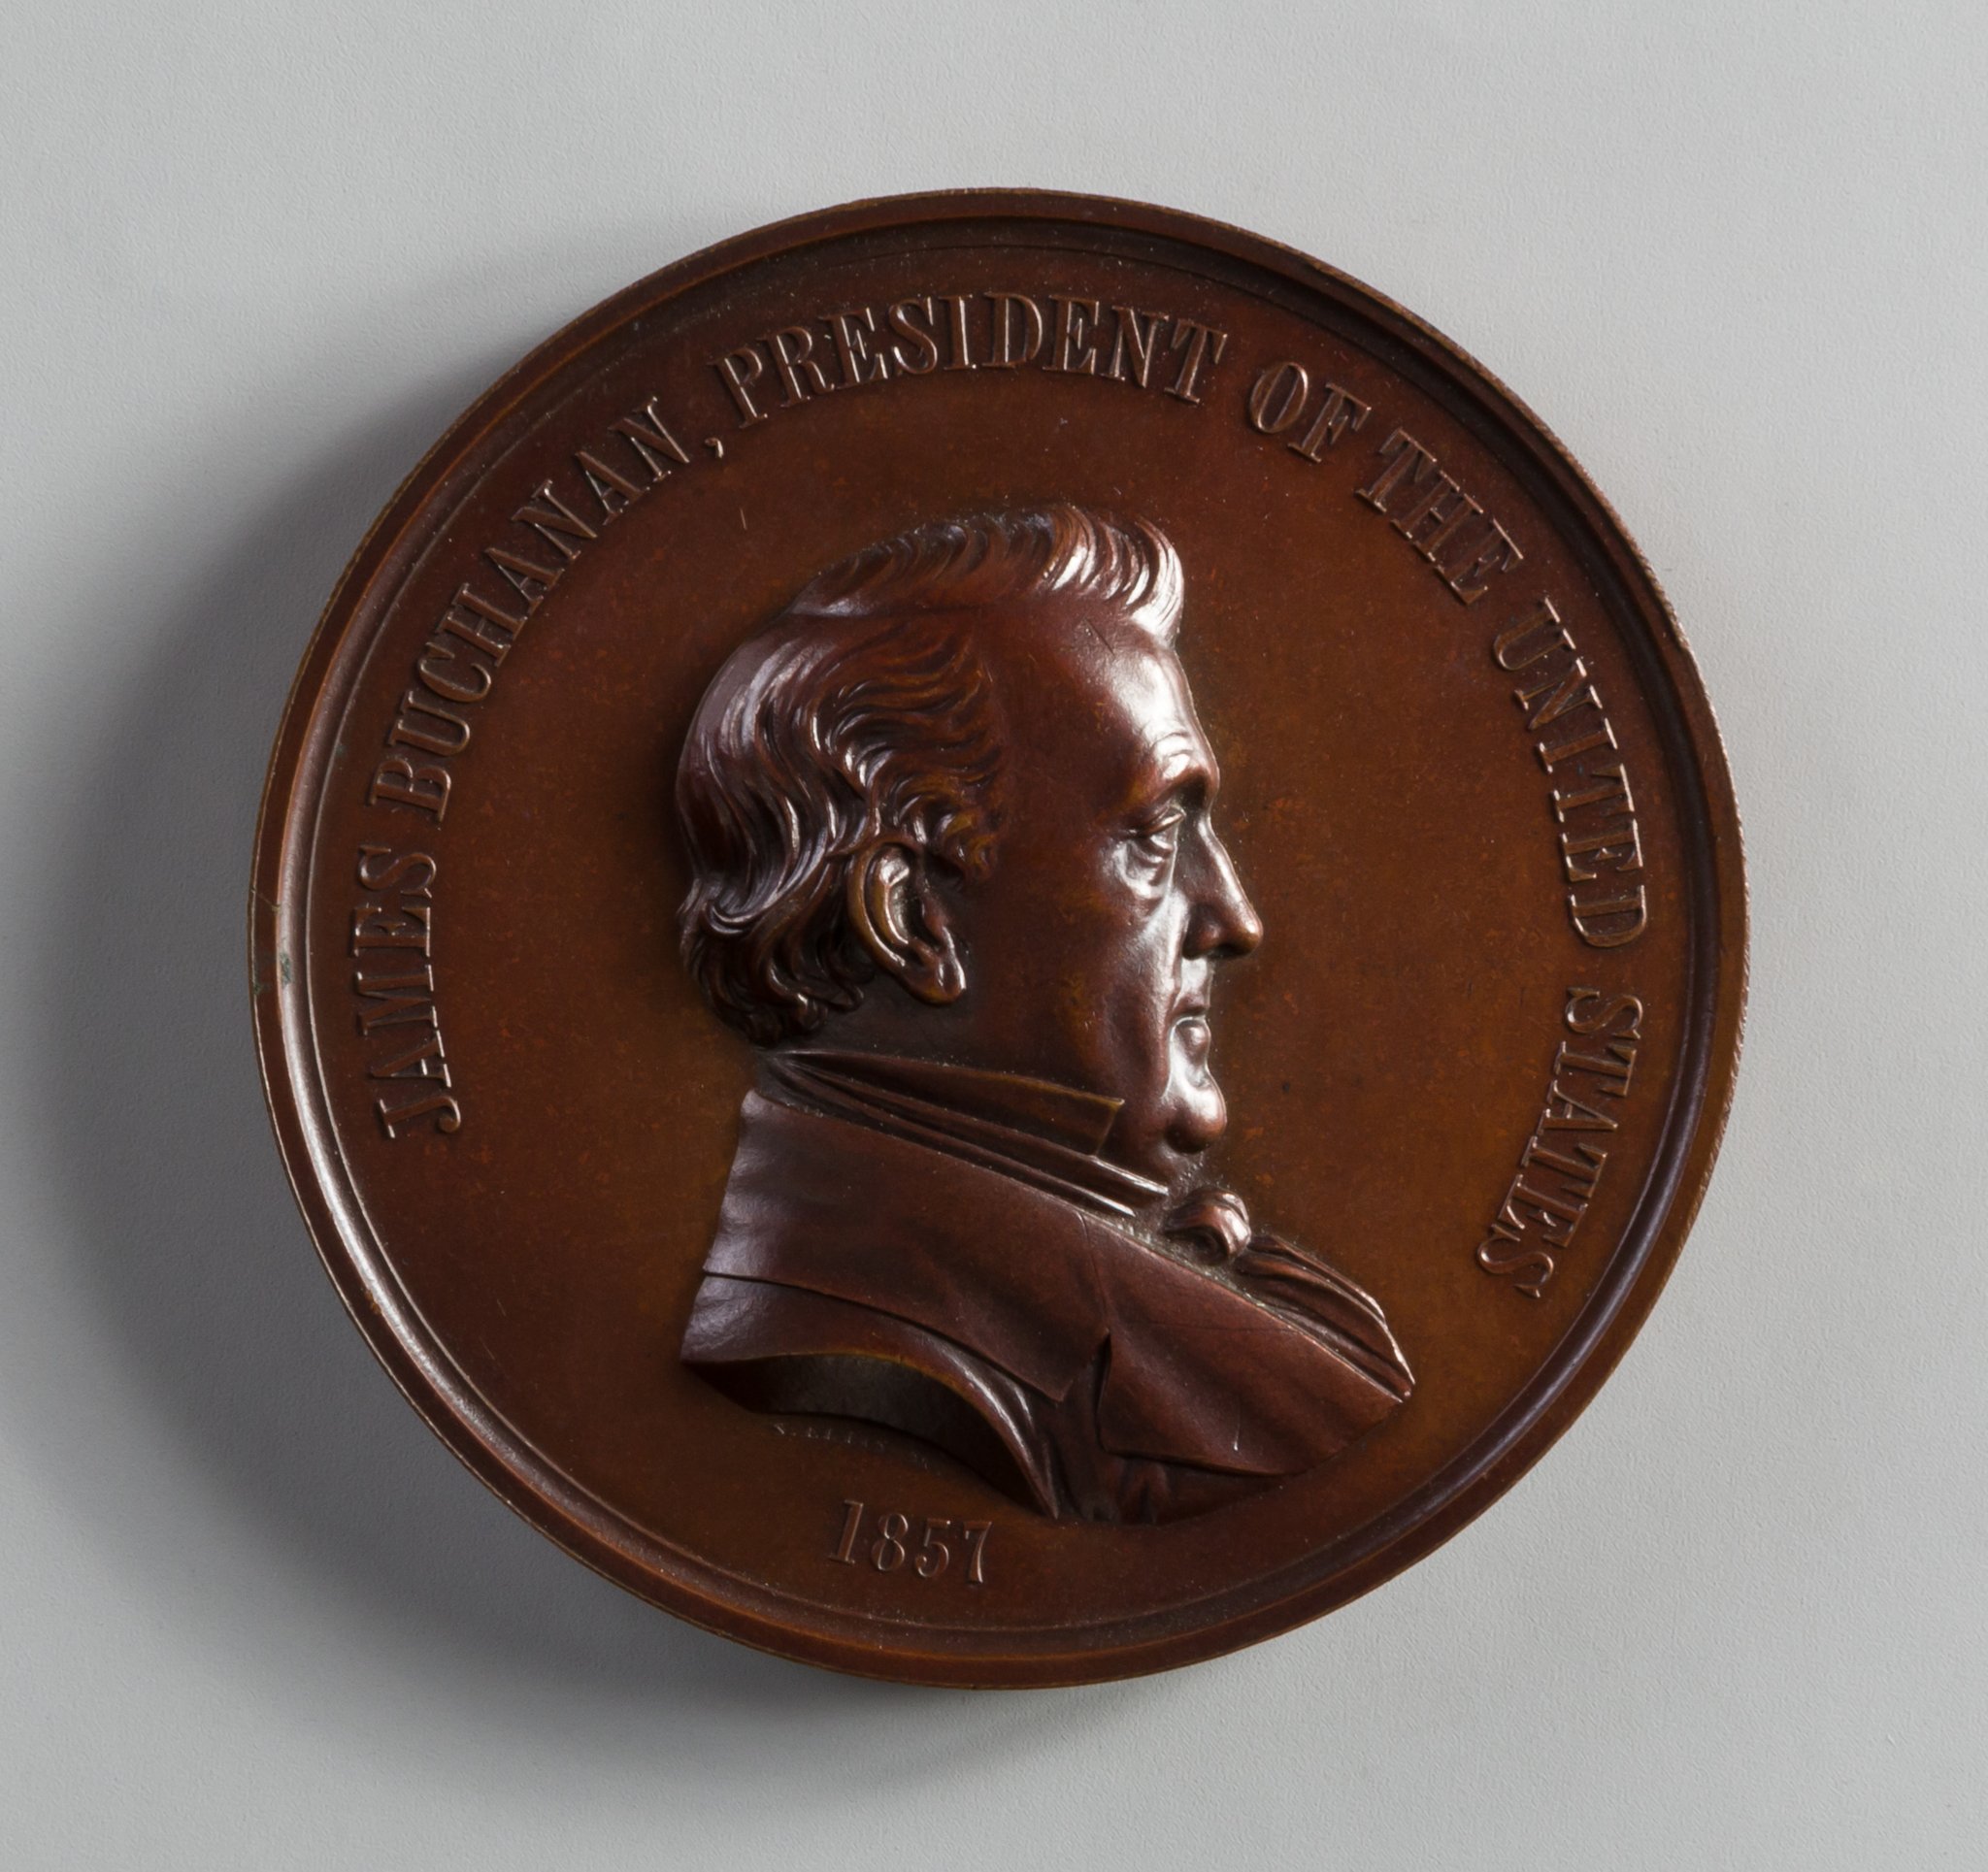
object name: medal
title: Medal of James Buchanan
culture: american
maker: salathiel ellis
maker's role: maker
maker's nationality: american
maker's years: 1803-1879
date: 1857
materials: bronze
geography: united states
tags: men,profiles